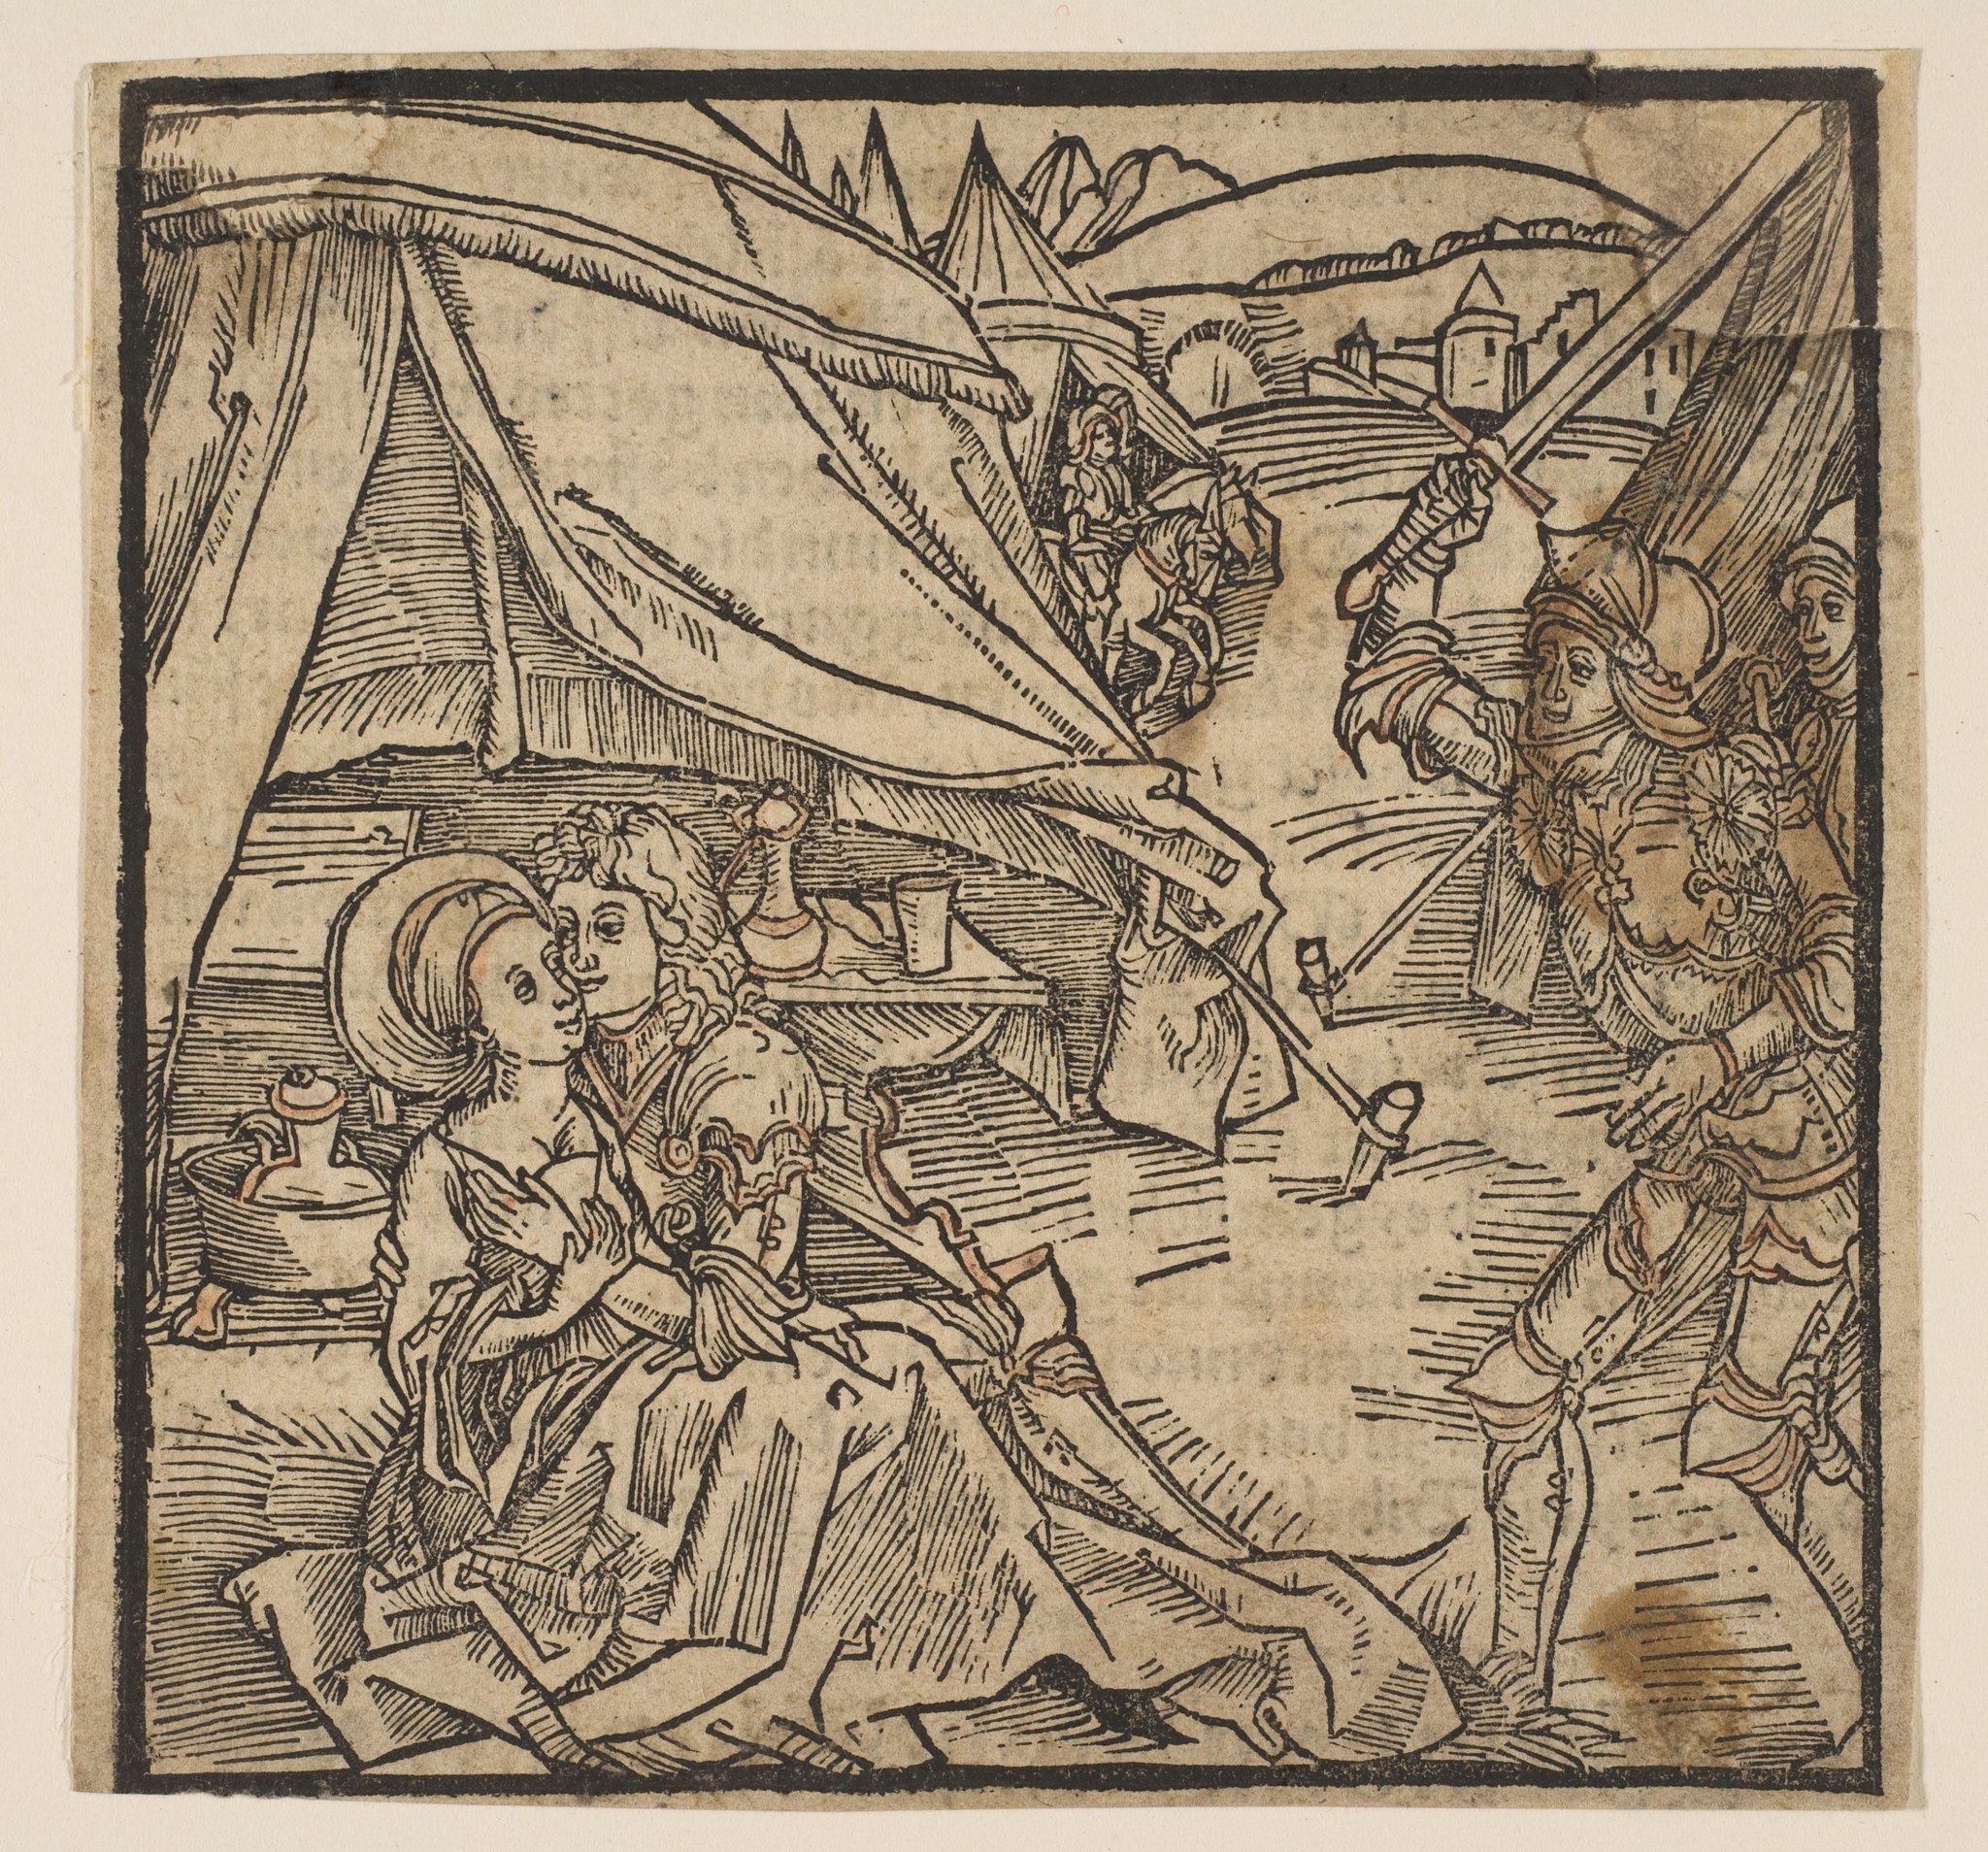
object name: print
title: Illustration from "The Ritter von Turn"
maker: albrecht dürer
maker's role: artist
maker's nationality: german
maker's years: 1471-1528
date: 1493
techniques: woodcut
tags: tents,men,women